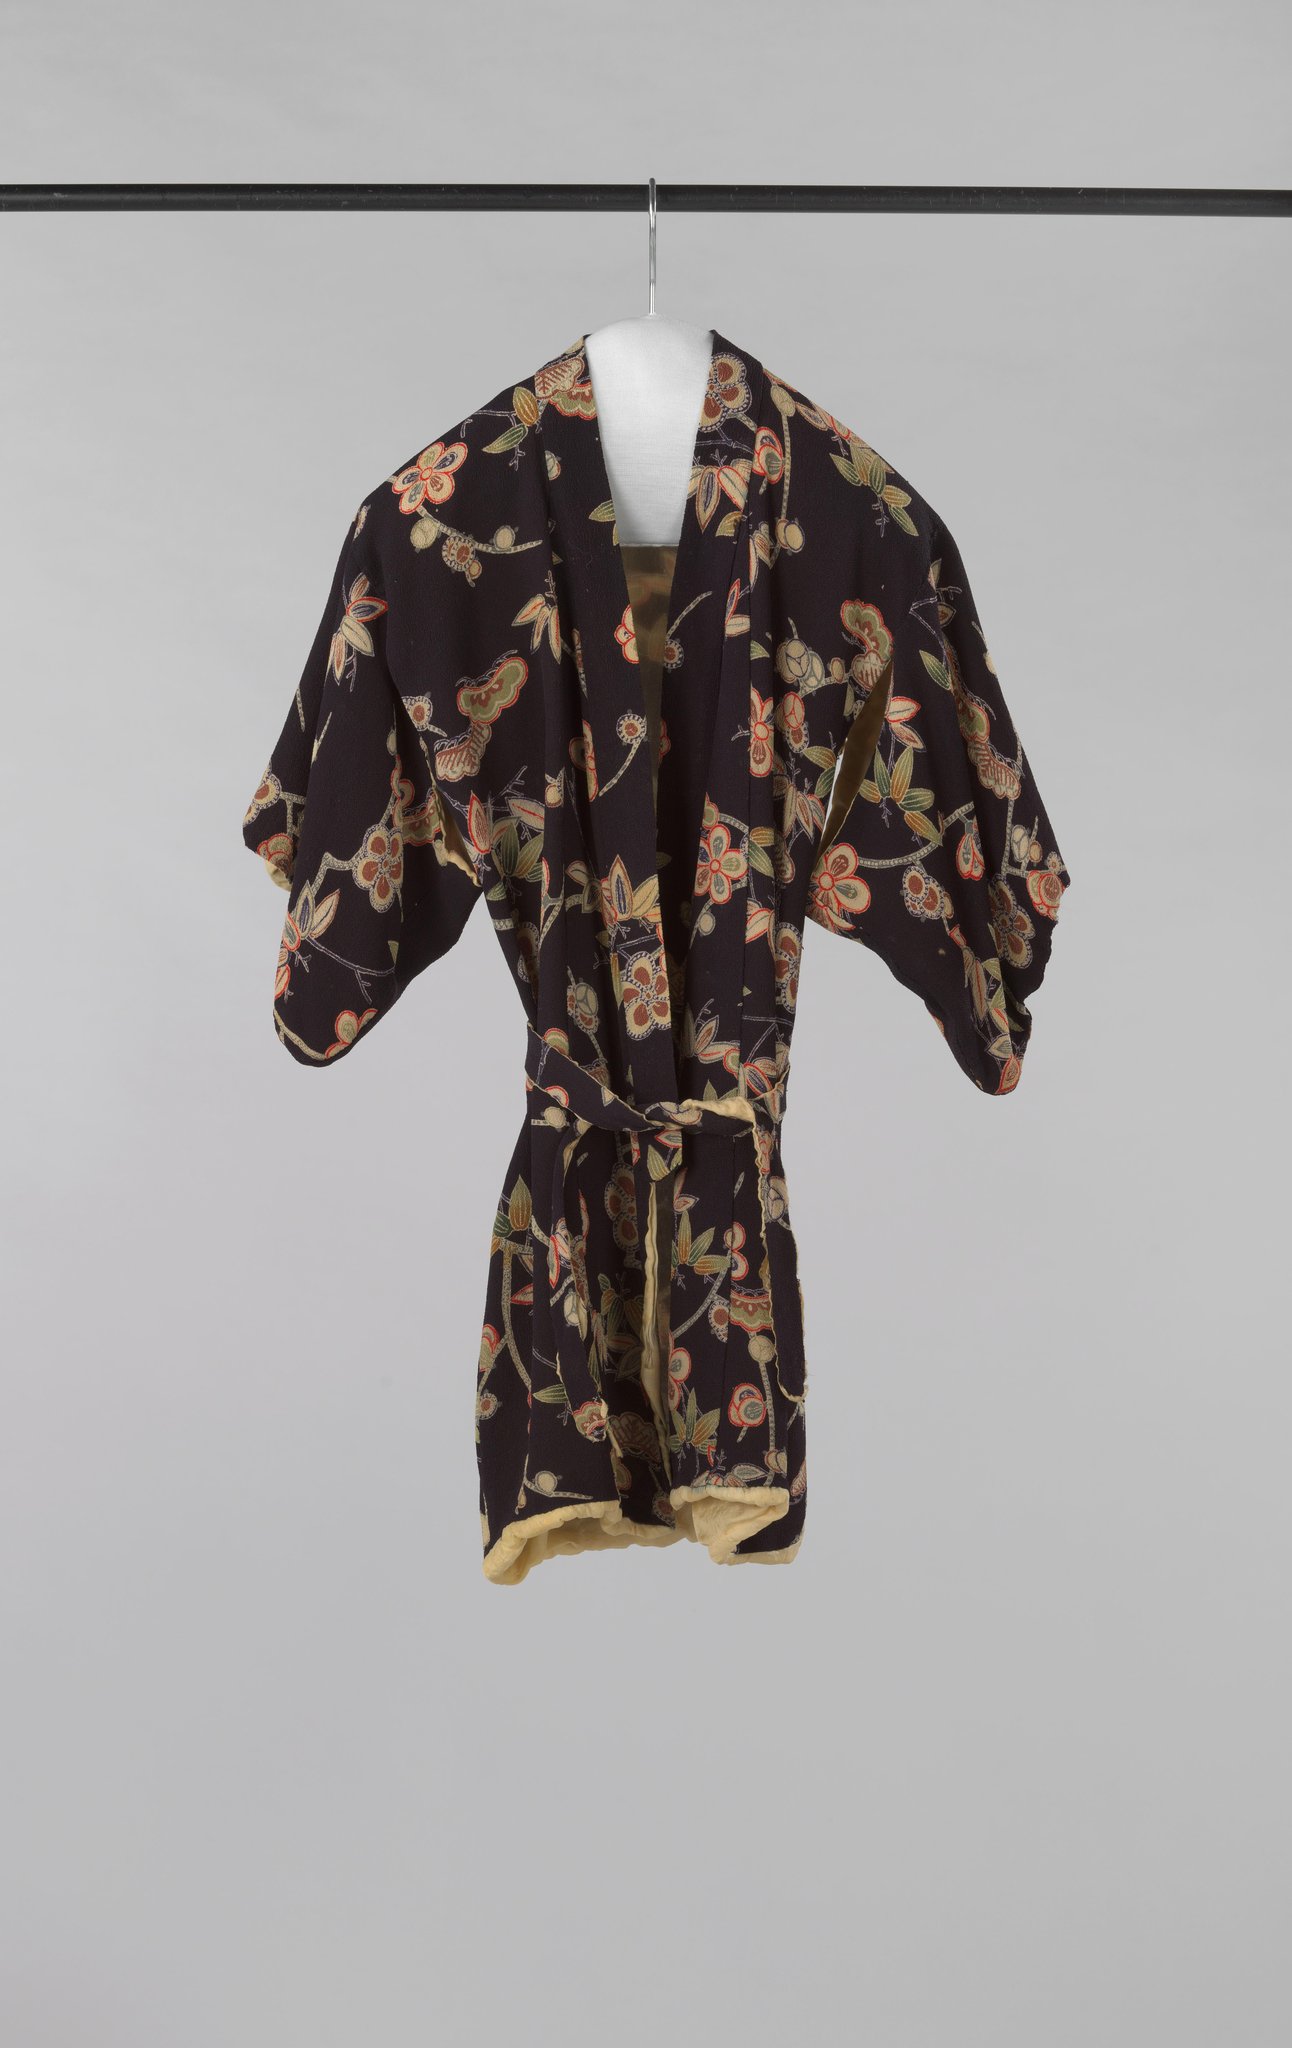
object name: childrenswear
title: Kinderkimono met korte mouw en oksel-openingen van donkerblauwe crêpe de Chine met meerkleurige bloem- en bladmotieven; voering beige zijde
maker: Anonymous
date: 1925-1950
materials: chine, silk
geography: japan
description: Kinderkimono van donkerblauwe crêpe de Chine met een veelkleurig floraal motief. Model met V-hals. Sluiting door middel van overslag en een losse bindceintuur. Aangezette, halflange mouwen met afhangende flap. Voering van effen beige zijde. Meegebracht uit Japan en gedragen door Herbert Hondius, zoon van de schenkster (zie foto).